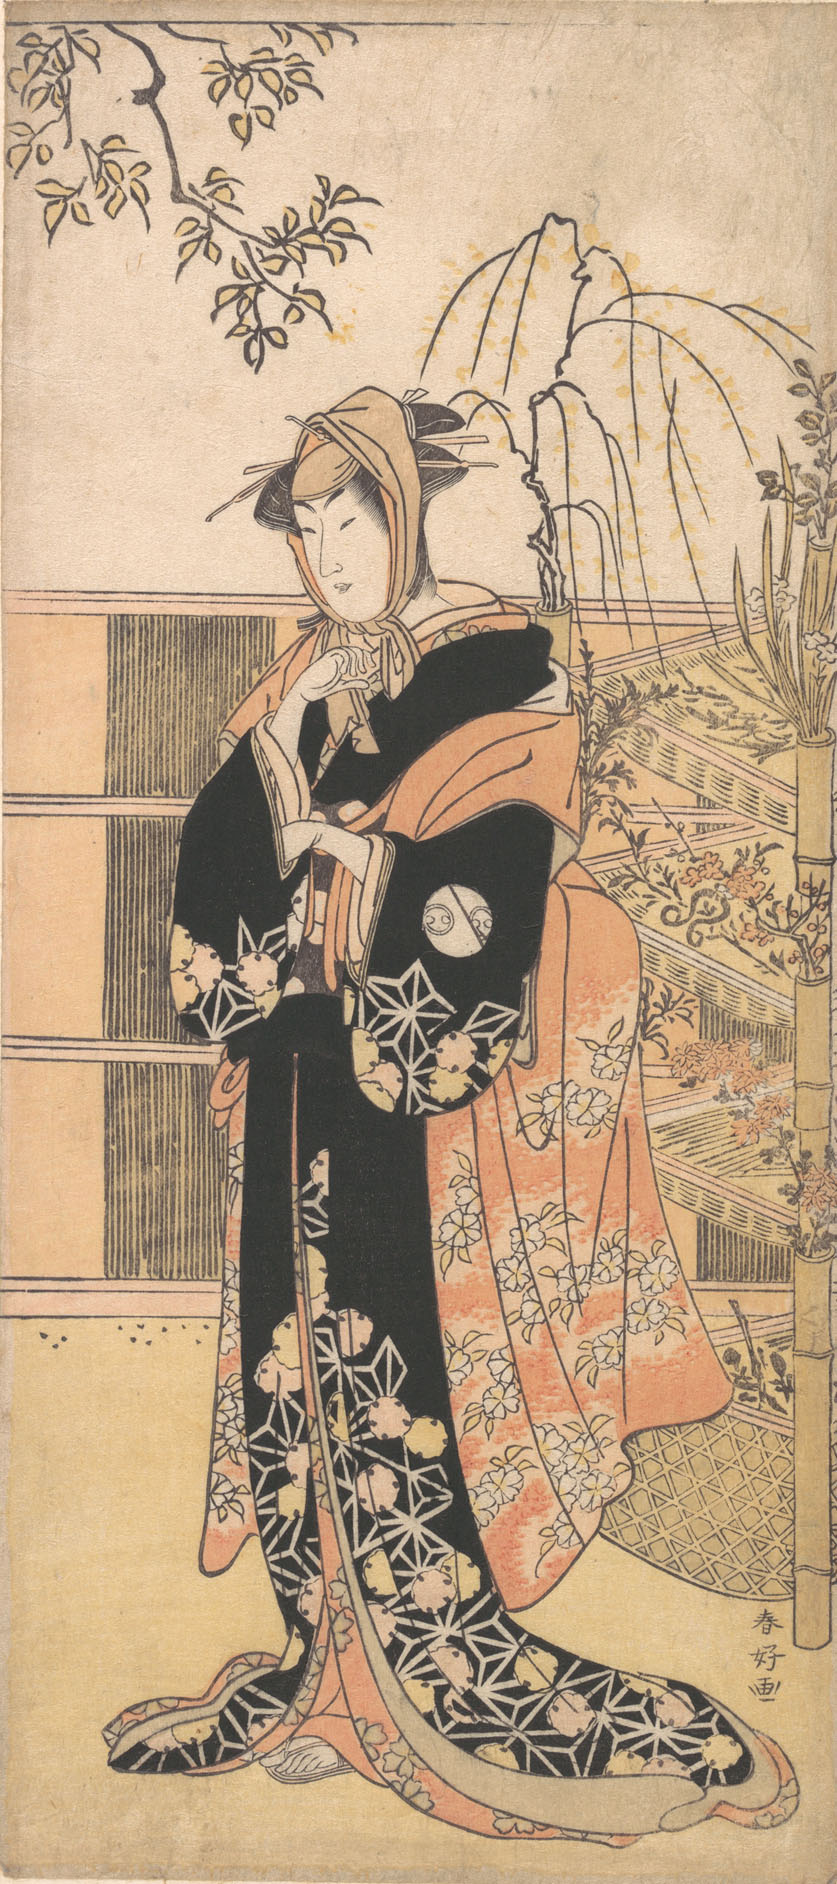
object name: print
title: Kabuki Actor Segawa Kikunojō III in a Woman’s Role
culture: japanese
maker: katsukawa shunkō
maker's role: artist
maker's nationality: japanese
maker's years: 1743-1812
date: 1780-1789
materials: ink, paper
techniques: woodblock print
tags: leaves,actors